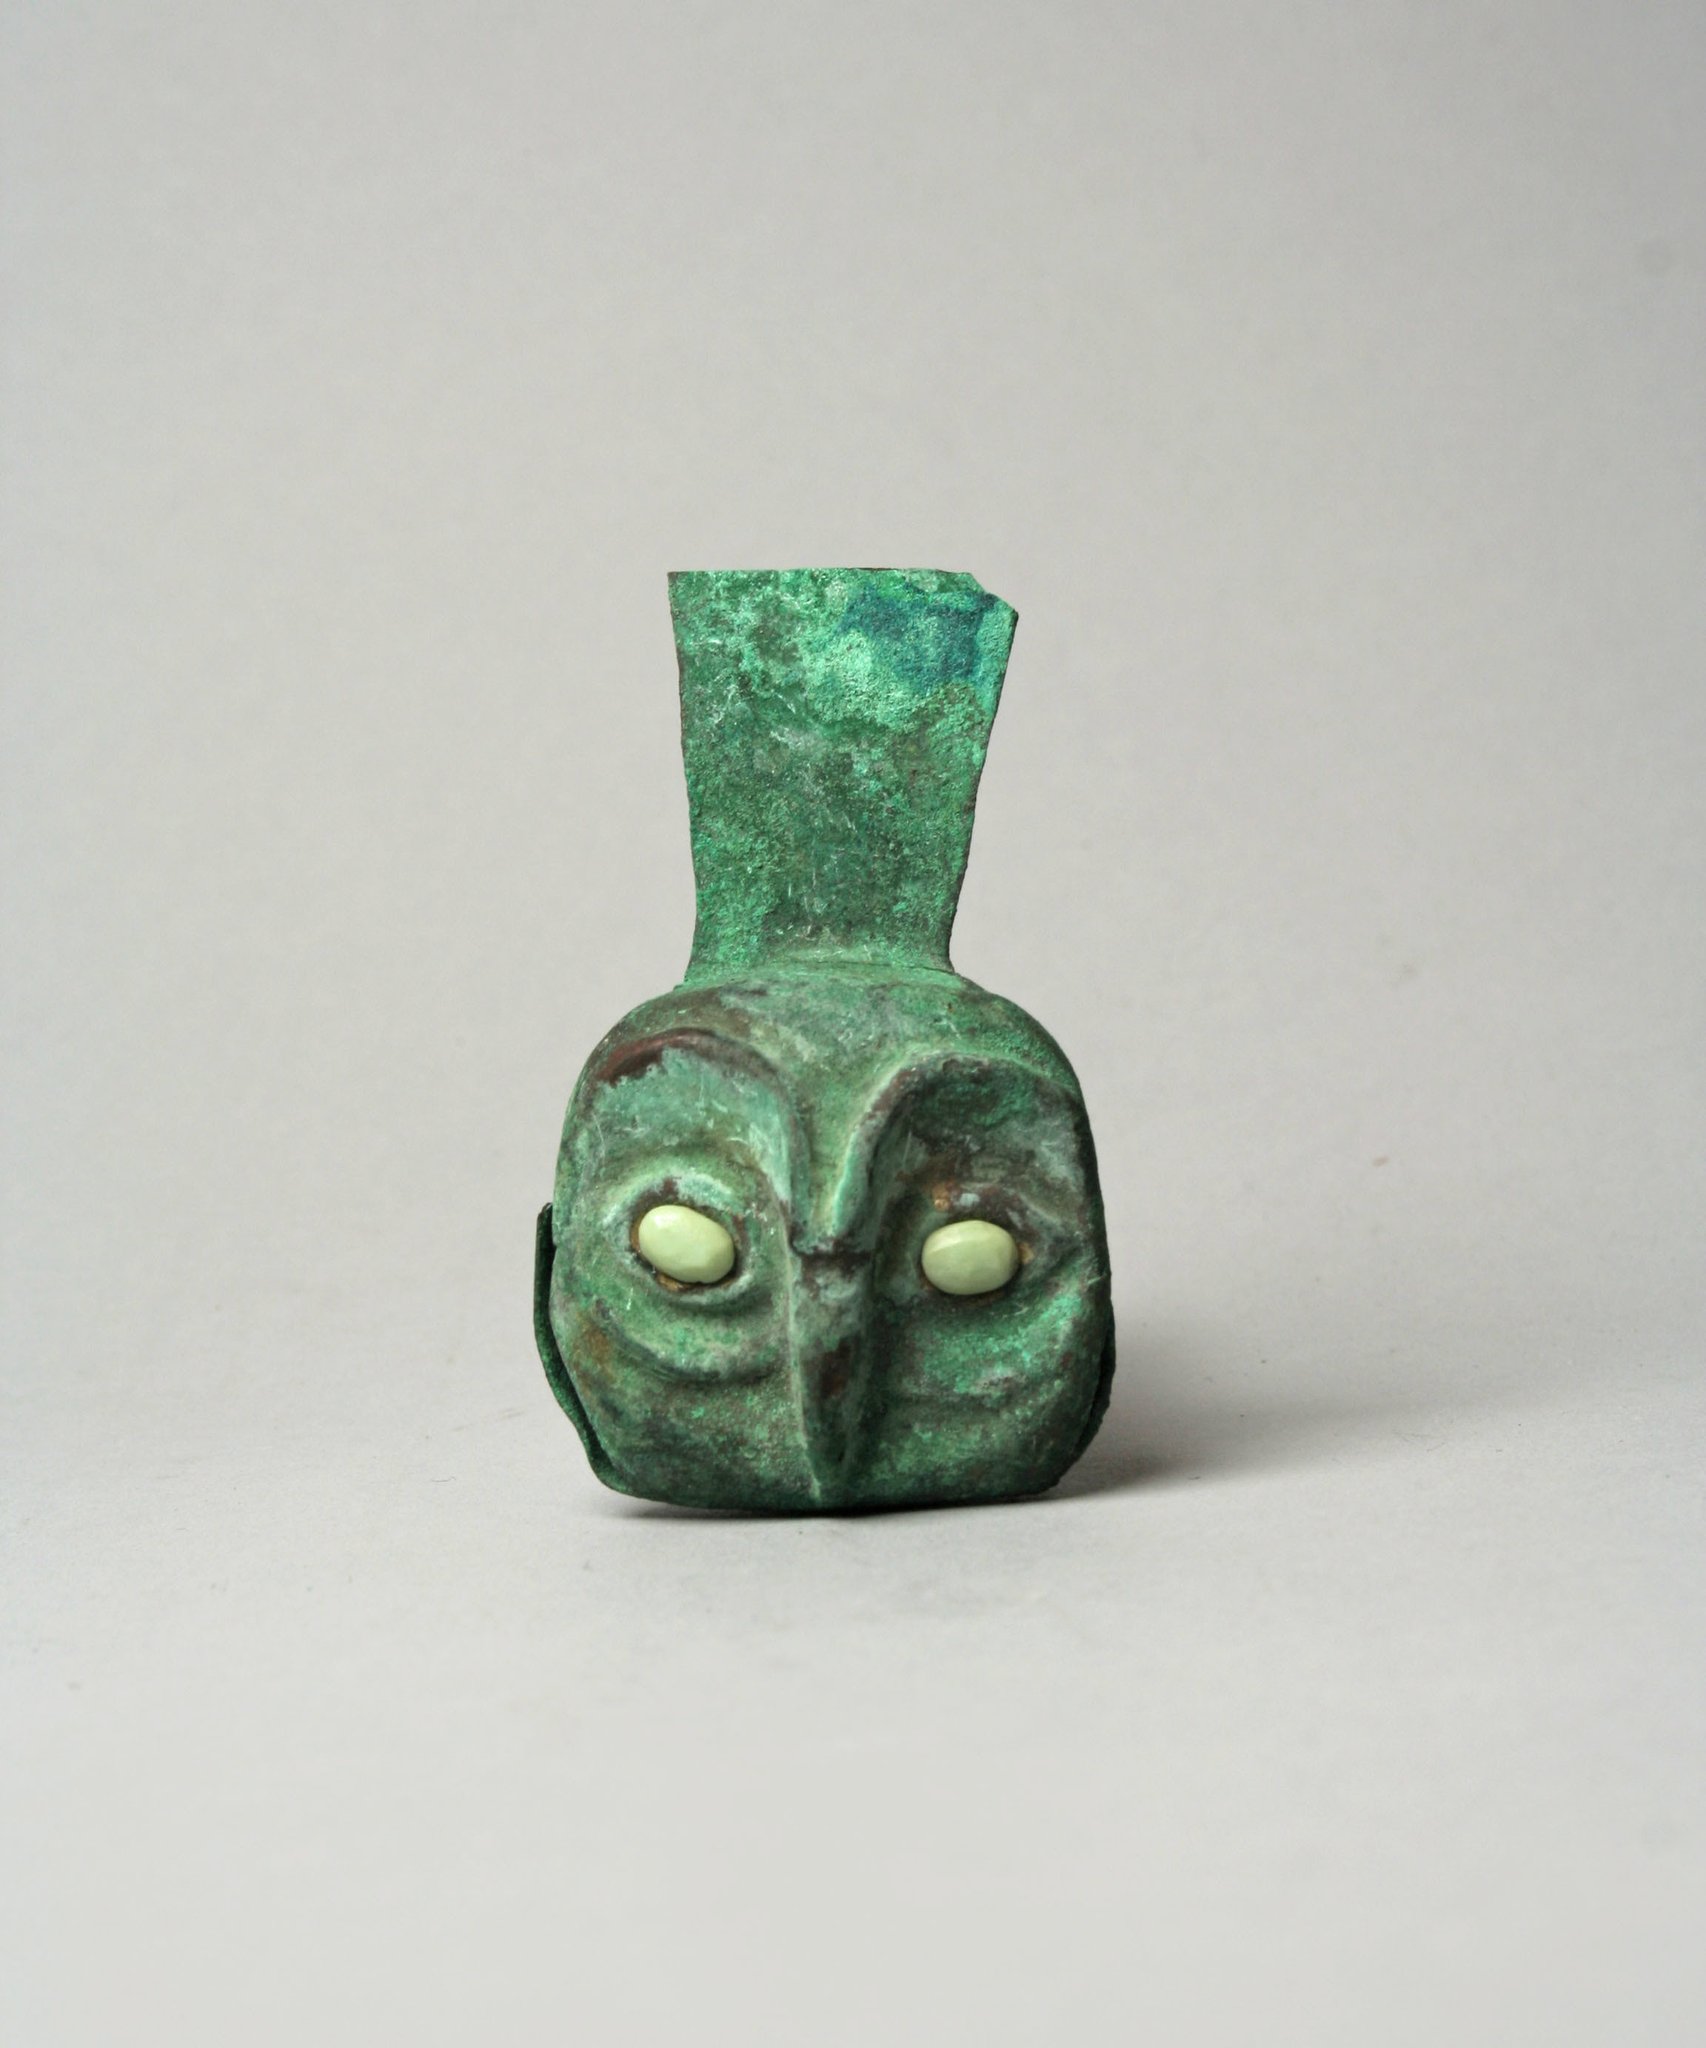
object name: ornament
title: Owl Tab Ornament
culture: moche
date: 501-700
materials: metal, stone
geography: peru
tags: owls